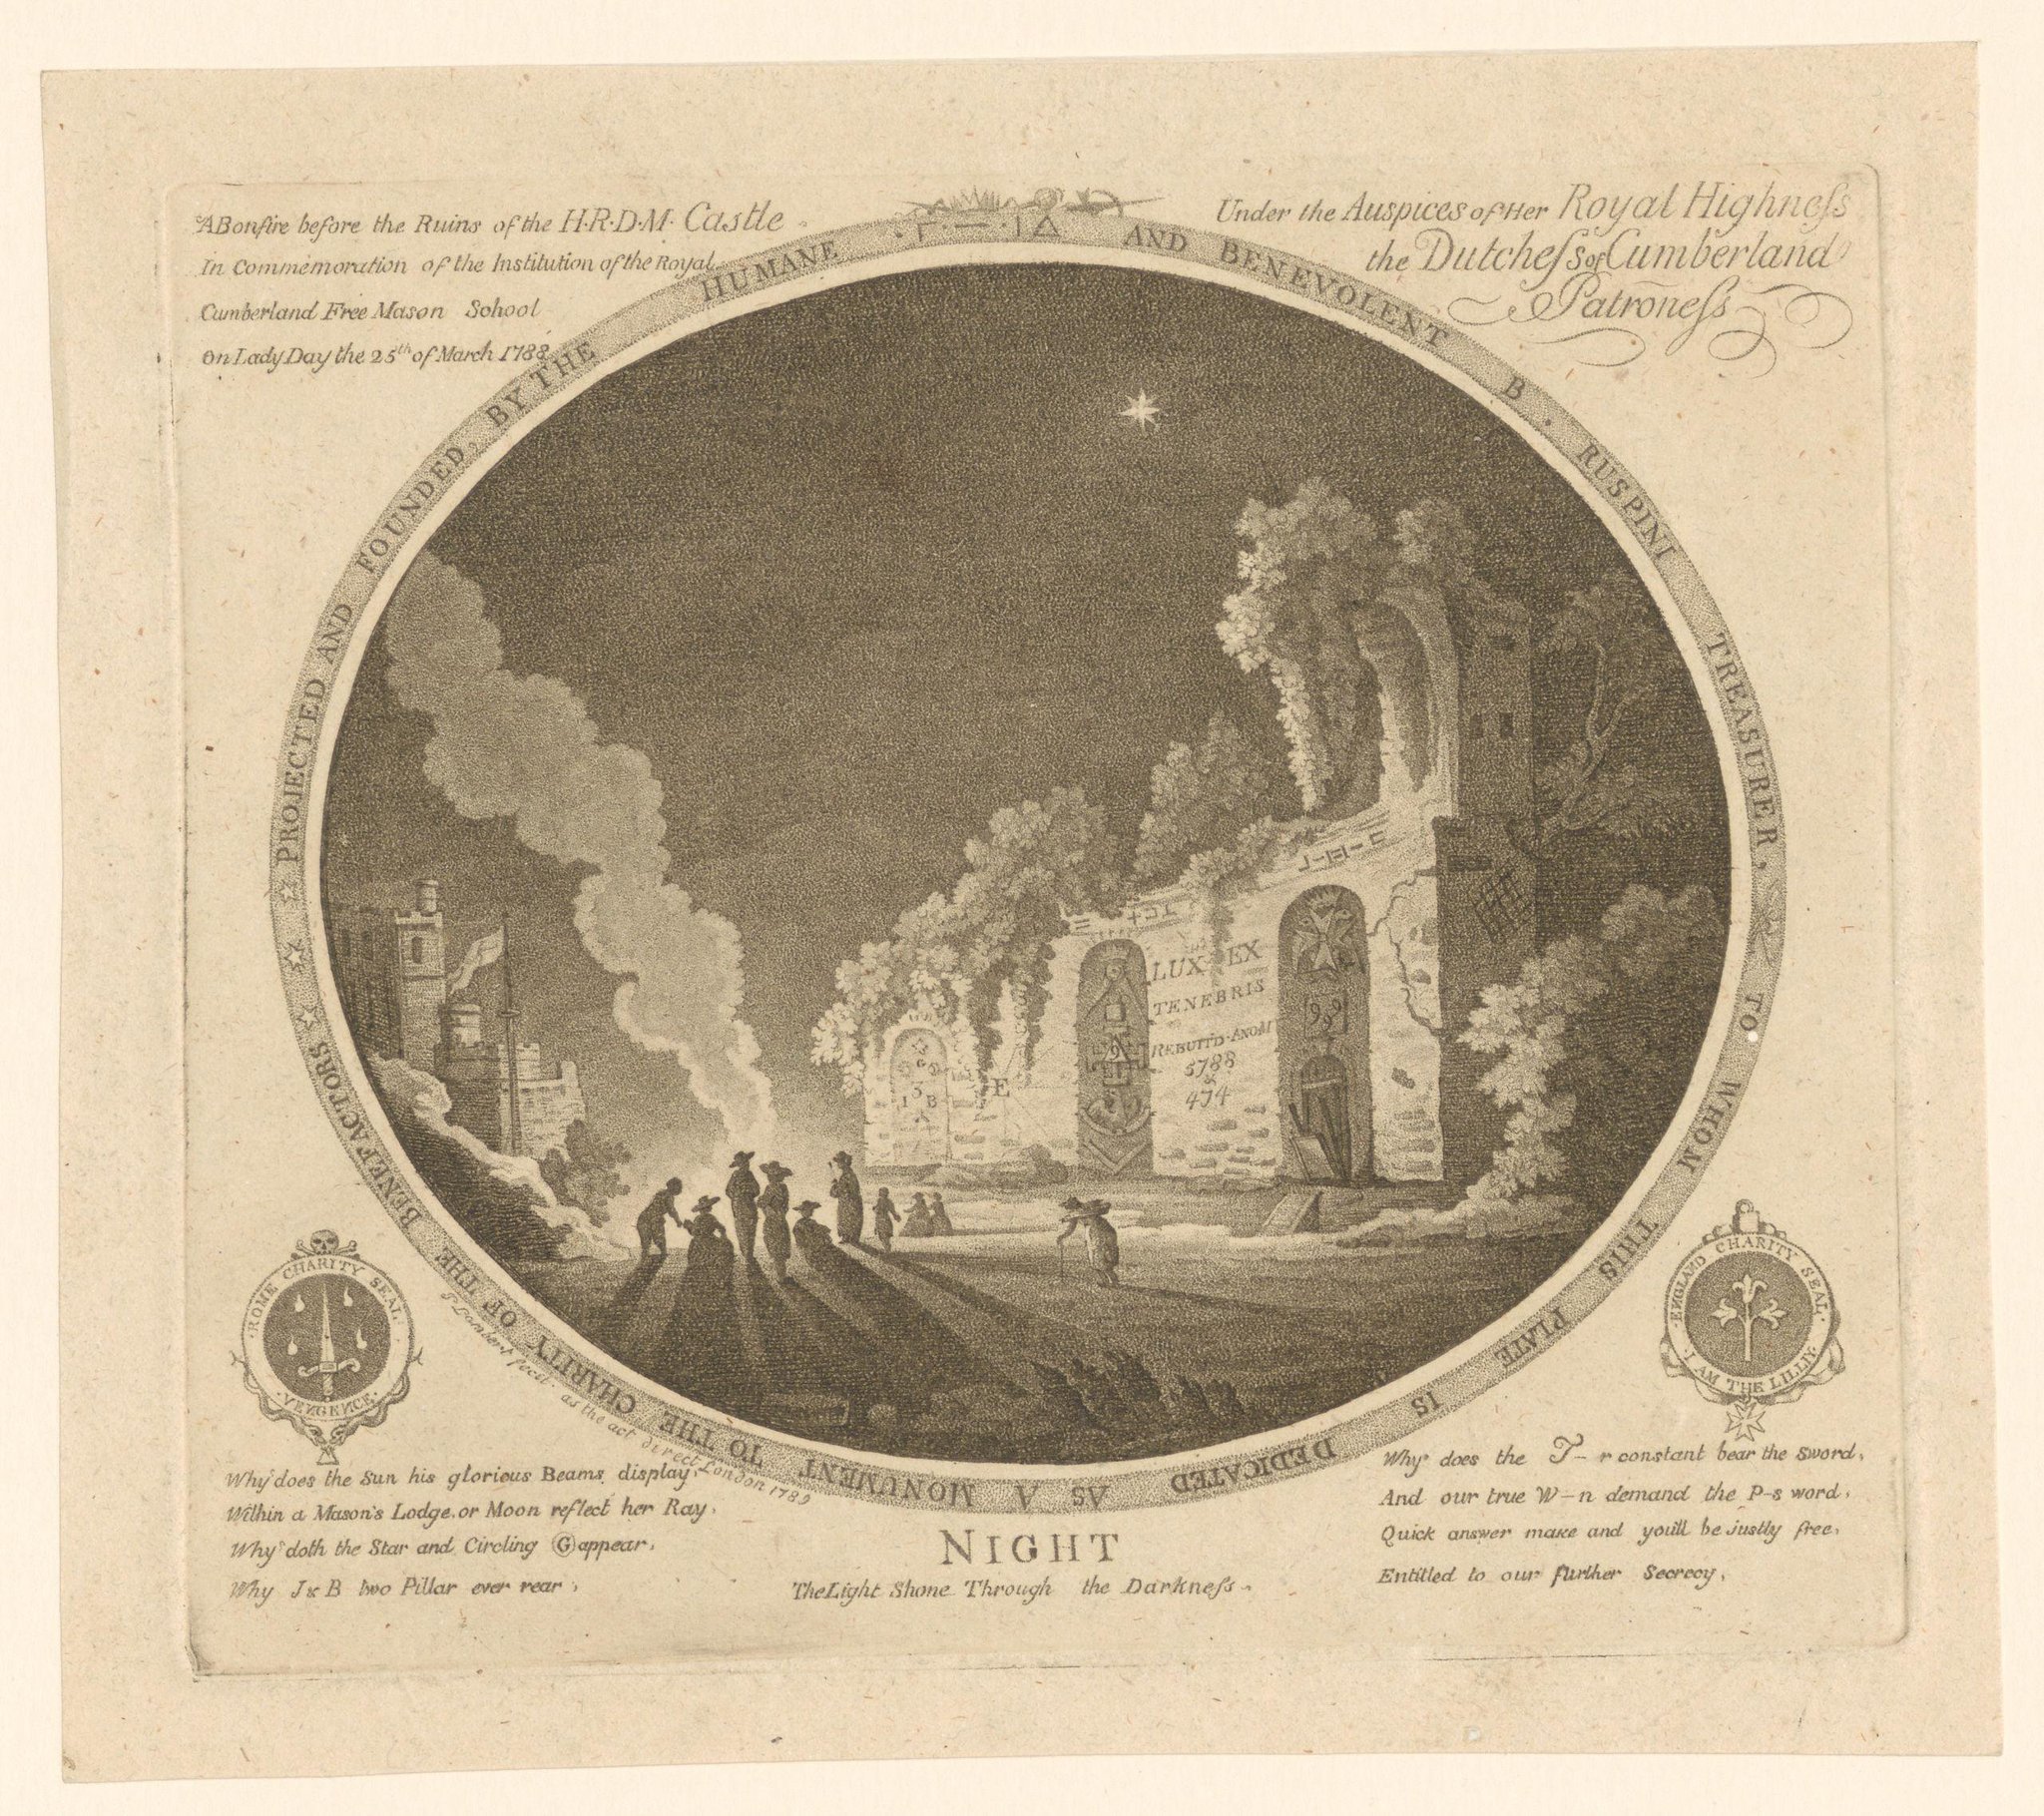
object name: print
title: Vrijmetselaarsymboliek op de verlichte muur van een ruïne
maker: p. lambert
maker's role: print maker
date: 1789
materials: paper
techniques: etching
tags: temple, shire ~ freemansonry, night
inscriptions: collector's mark: Lugt 2228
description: Tekst in het Engels in de marges en de omlijsting, daarbij twee ordetekens. De centrale voorstelling bevat rituelen en vrijmetselaars die bij een groot vuur staan dat de muur van de ruïne verlicht. Daaronder staat: 'Night The light shone through the Darkness'.